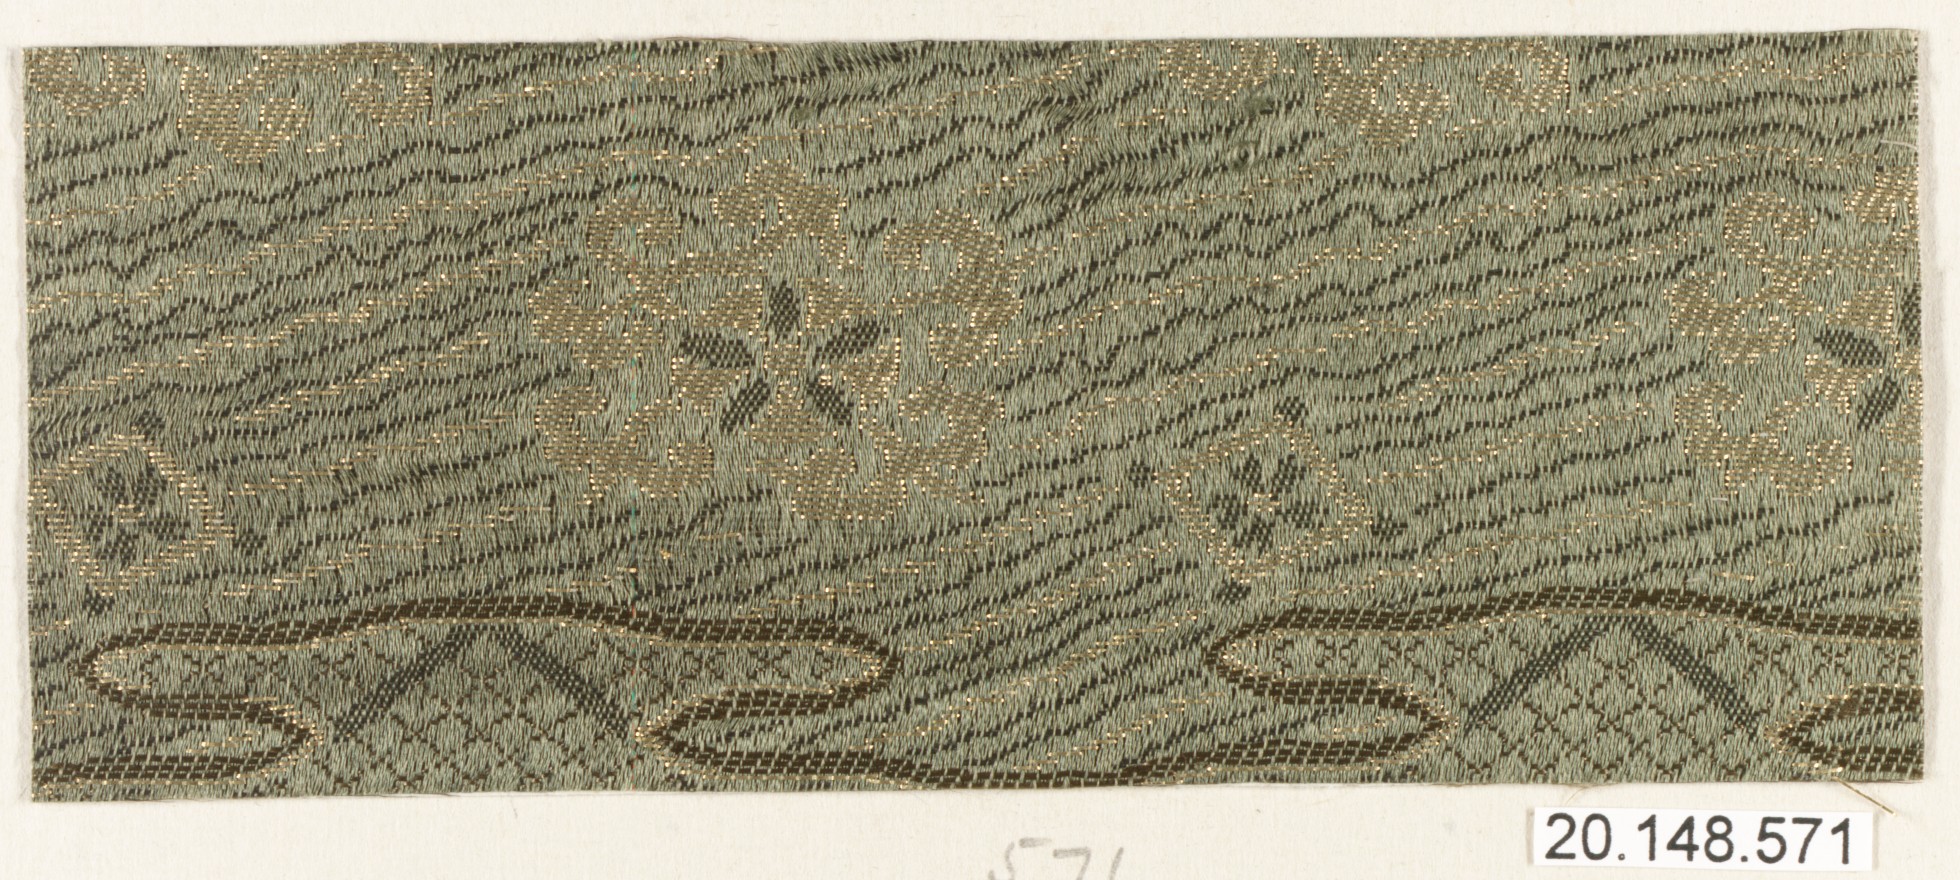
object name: piece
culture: japanese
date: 1701-1800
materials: silk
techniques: compound weave